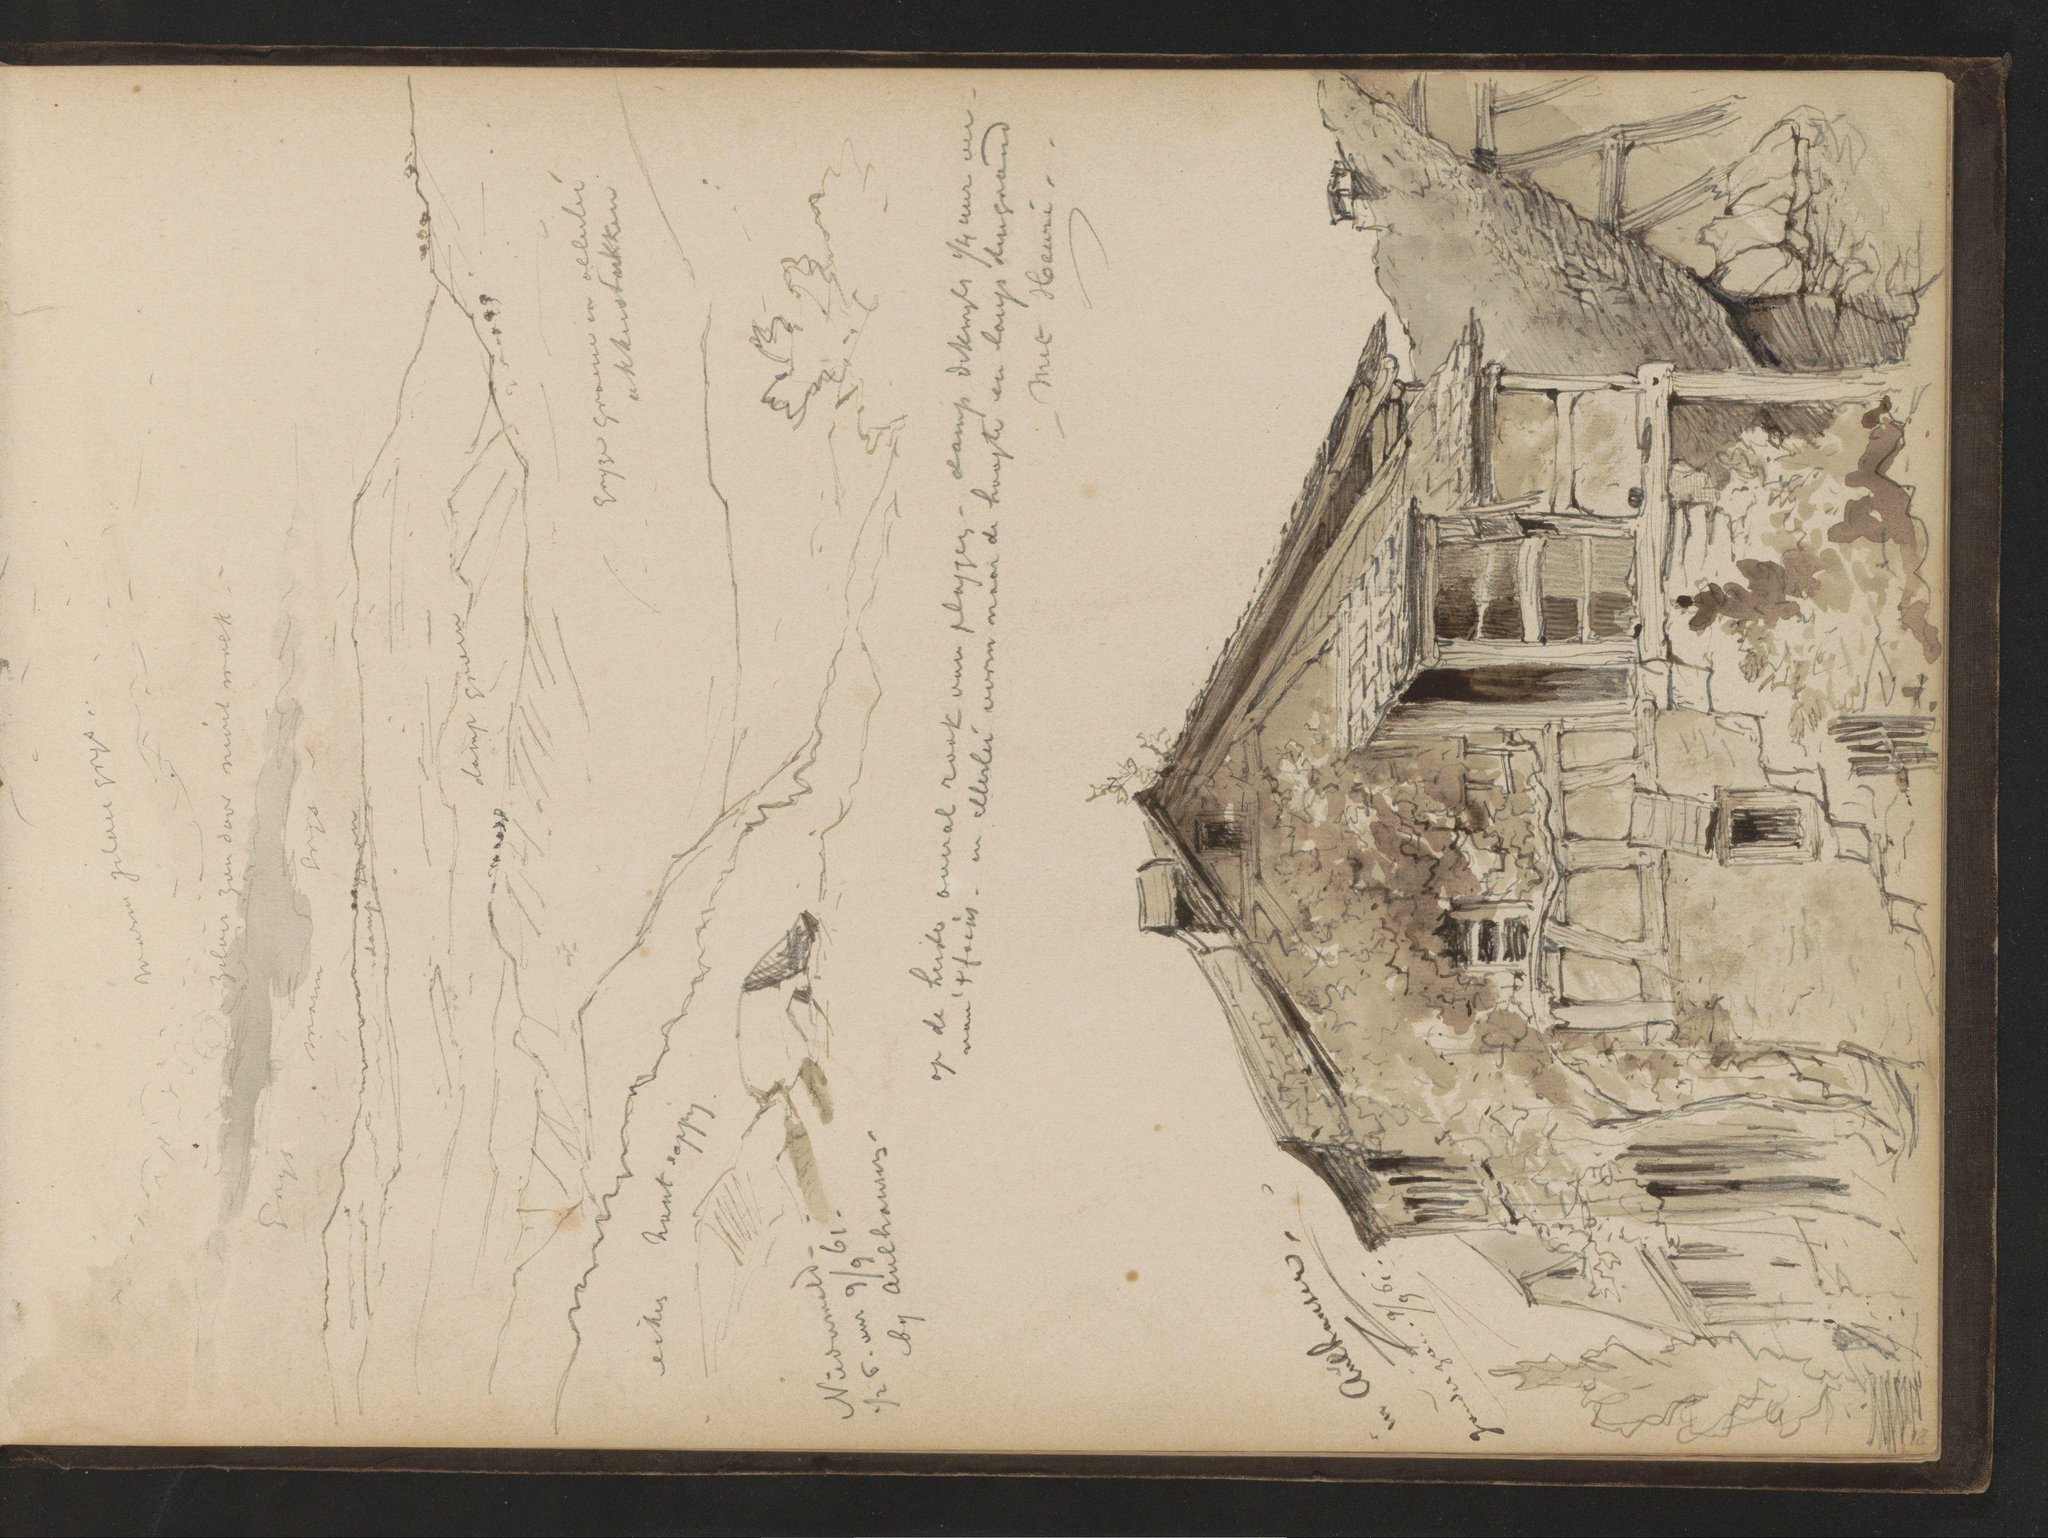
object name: sketchbook leaf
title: Heide in Niederwald en een huis in Aulhausen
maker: johannes tavenraat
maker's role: draughtsman, painter, print maker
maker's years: 1809-1881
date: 1809-1861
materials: ink, paper, pencil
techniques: brush, pen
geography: rüdesheim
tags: rural housing, e.g. country-house, villa, cottage, mountains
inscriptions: date and inscription: ‘Niederwald/ 1/2 5 uur 9/9 61/bij Aulhausen/ in Aulhausen/ zonder zon - 9/9 61/ op de heide overal rook van plaggen [...]/ met Henri’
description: Blad 18 recto uit een schetsboek met 57 bladen.